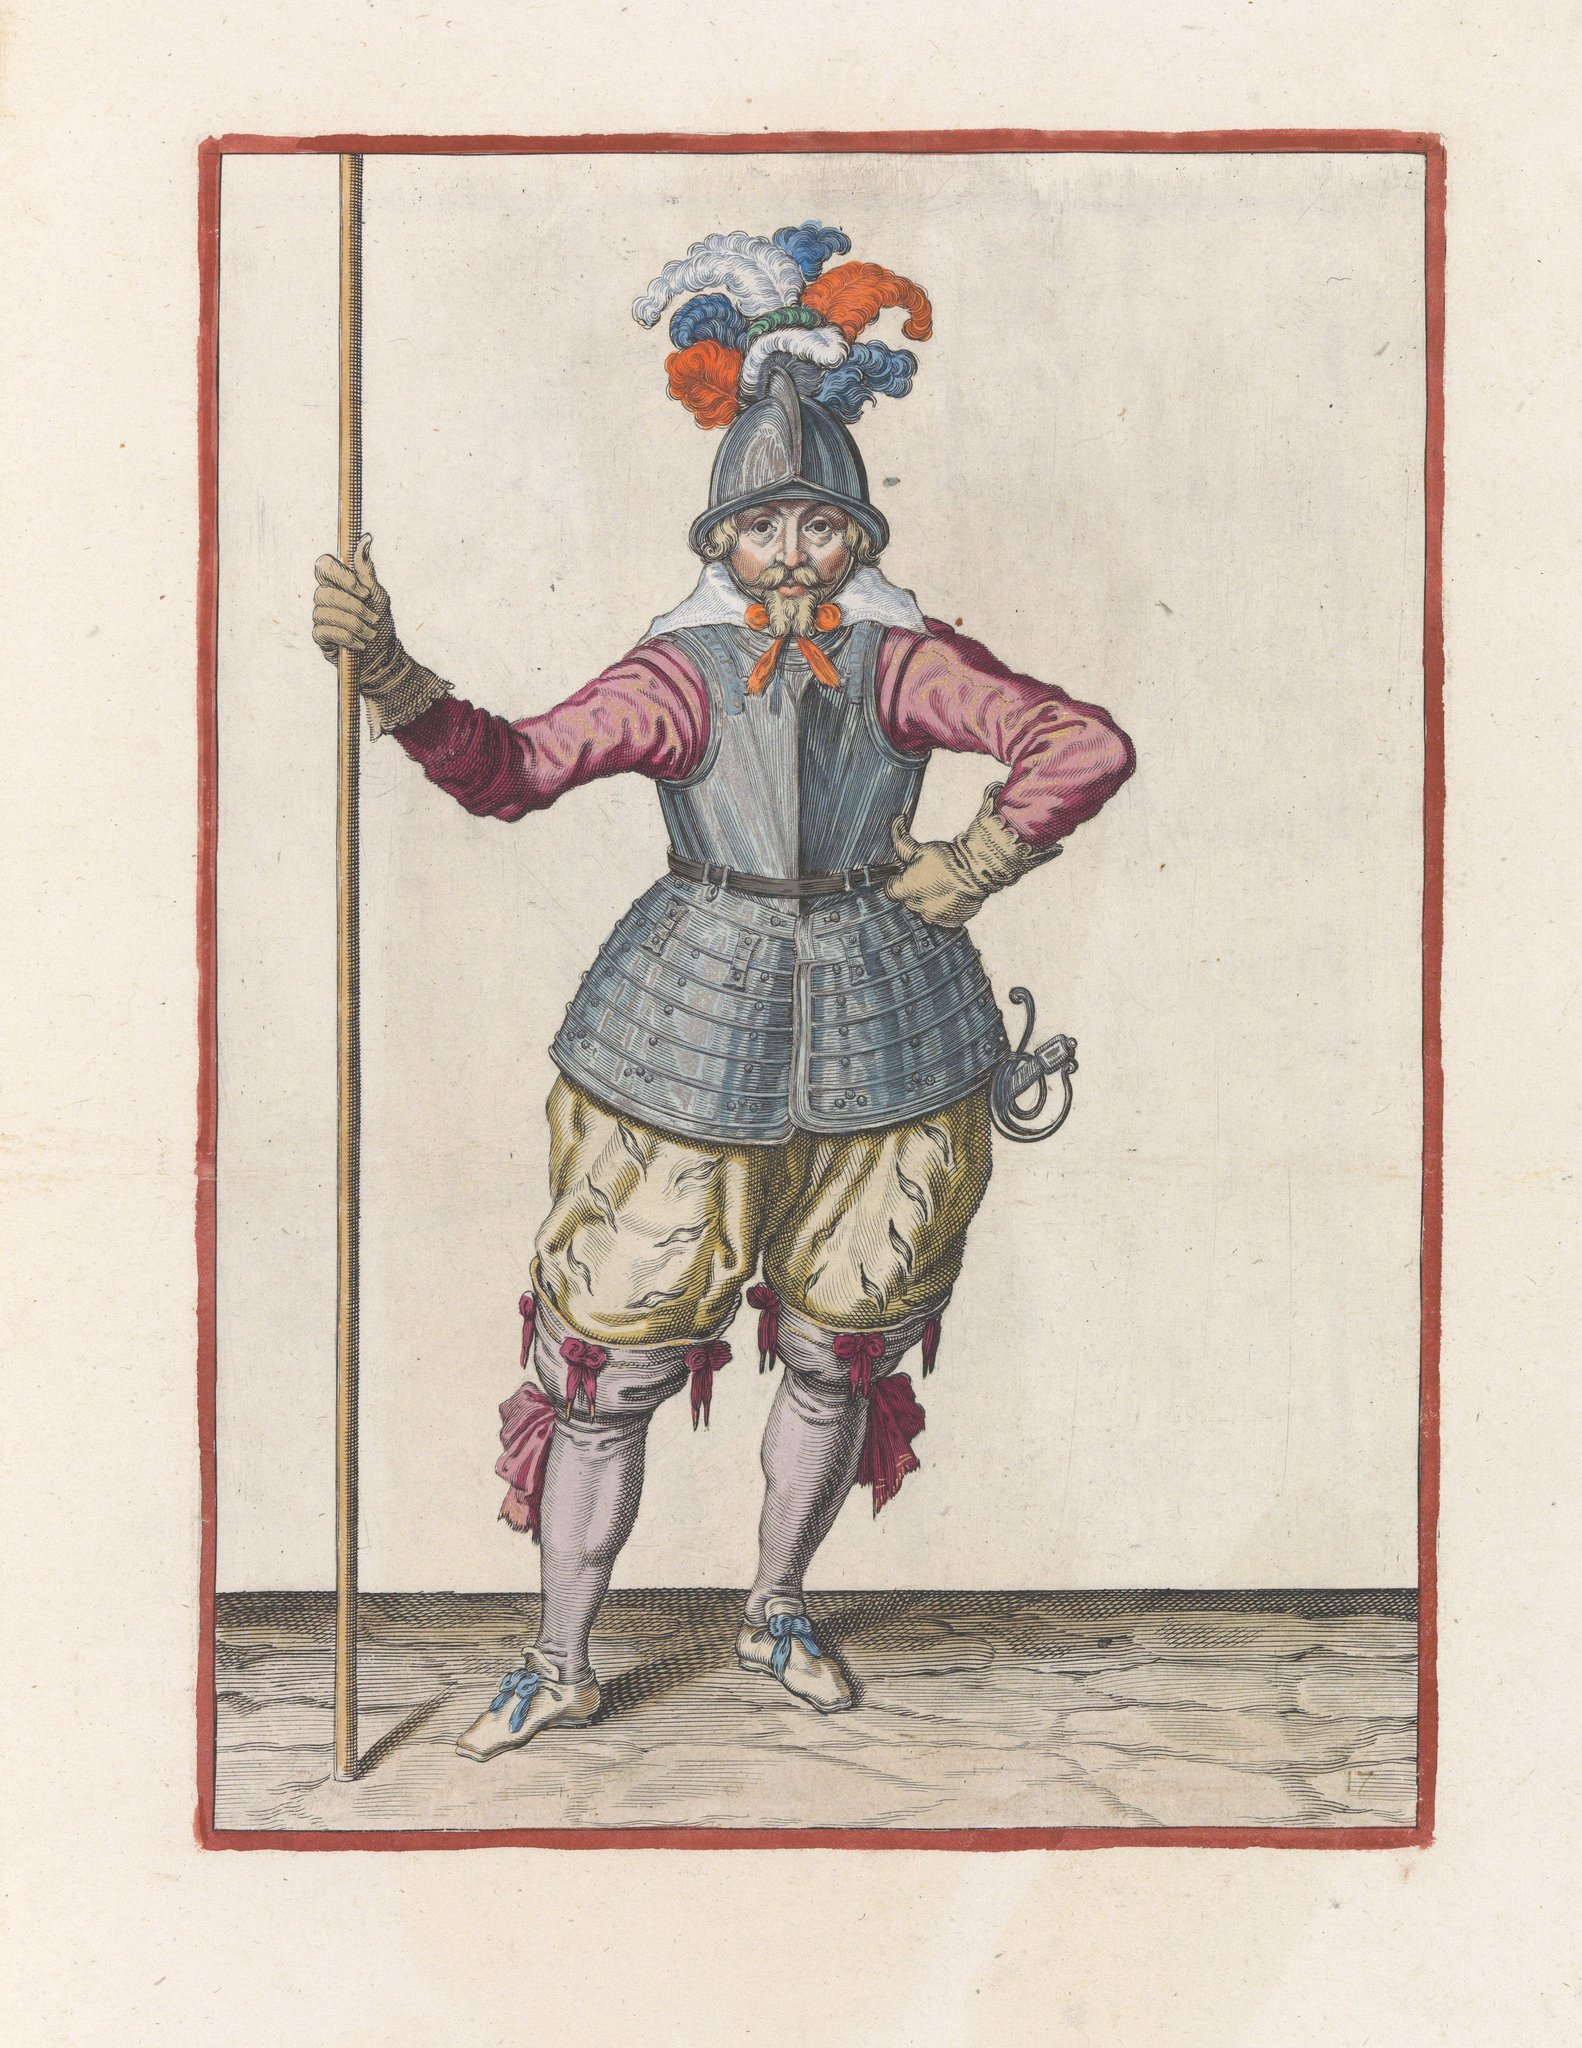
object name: print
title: Soldaat, van voren gezien, die zijn spies met zijn rechterhand rechtop vasthoudt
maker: jacques de gheyn (ii)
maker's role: painter, print maker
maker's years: 1565-1629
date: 1597-1607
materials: paper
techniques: engraving, hand coloring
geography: the hague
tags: handling of weapons ~ military training, helved weapons, polearms (for striking, hacking, thrusting): lance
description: Een soldaat, ten voeten uit, die een spies (lans) met zijn rechterhand rechtop vasthoudt. Deze prent is onderdeel van de reeks van 32 met de hand genummerde prenten van spiesdragers in de Wapenhandelinghe.